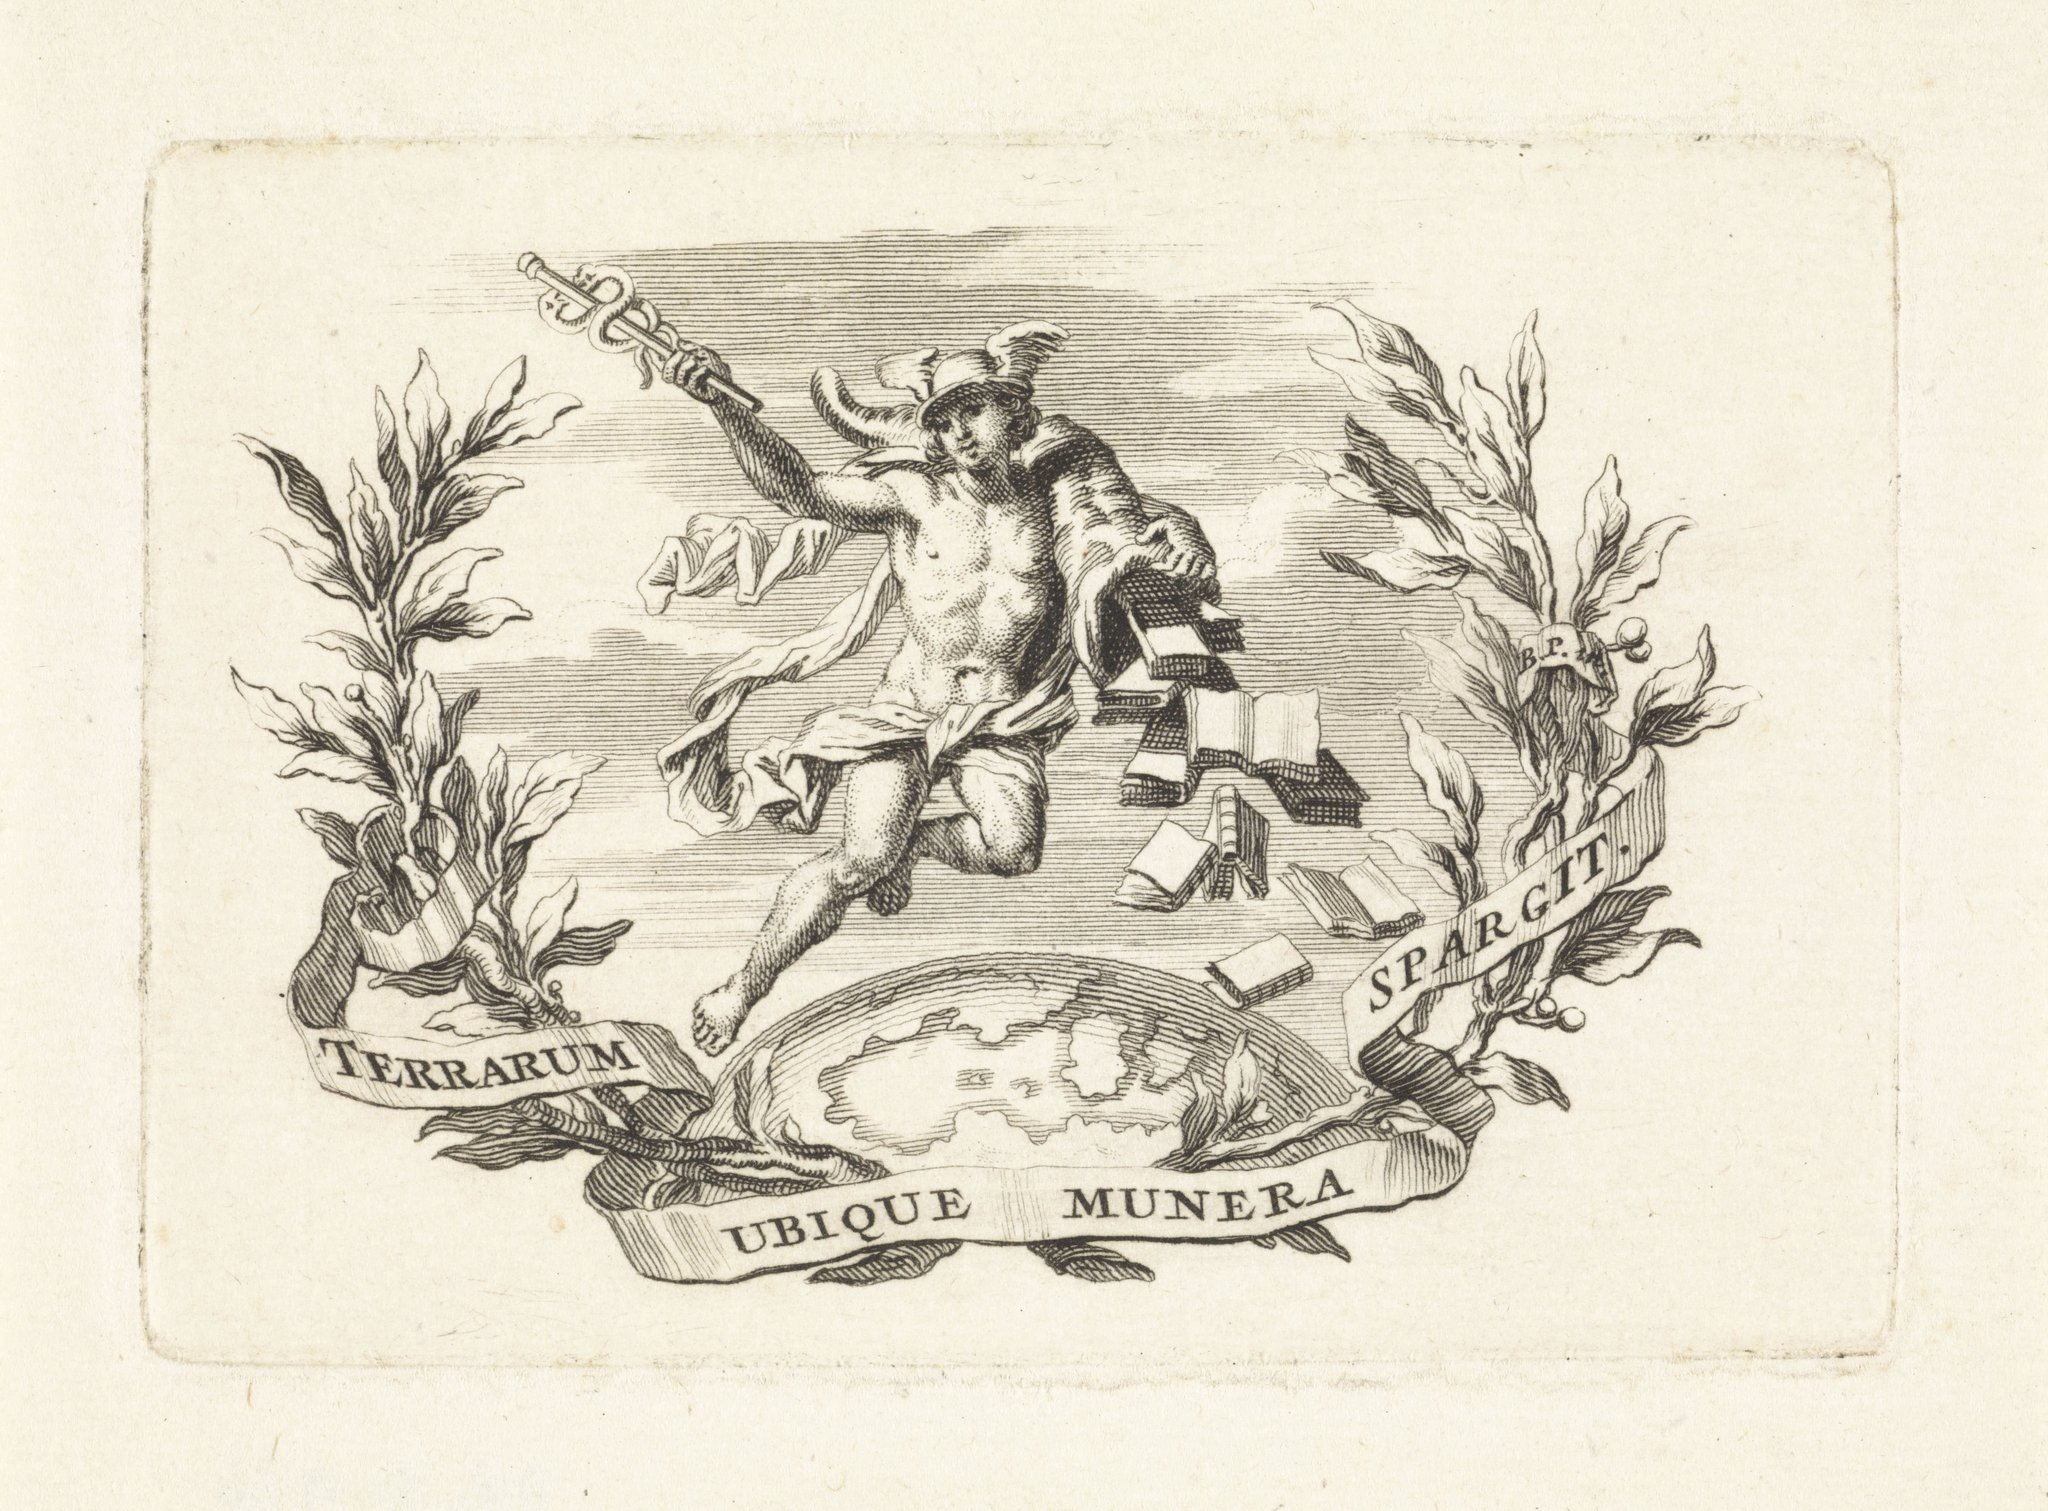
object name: book illustration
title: Mercurius strooit boeken over de aarde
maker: bernard picart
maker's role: draughtsman, print maker, publisher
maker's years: 1673-1733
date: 1683-1733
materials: paper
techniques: engraving, etching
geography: amsterdam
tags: specific aspects, allegorical aspects of mercury; mercury as patron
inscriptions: collector's mark: Lugt 2228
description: Prent mogelijk gebruikt in: Téos, Anacréon de. Les odes d'Anacreon et de Sapho. [Vertaald uit het Grieks door] François Gacon. Rotterdam: Caspar Fritsch en Michael Böhm, 1712.